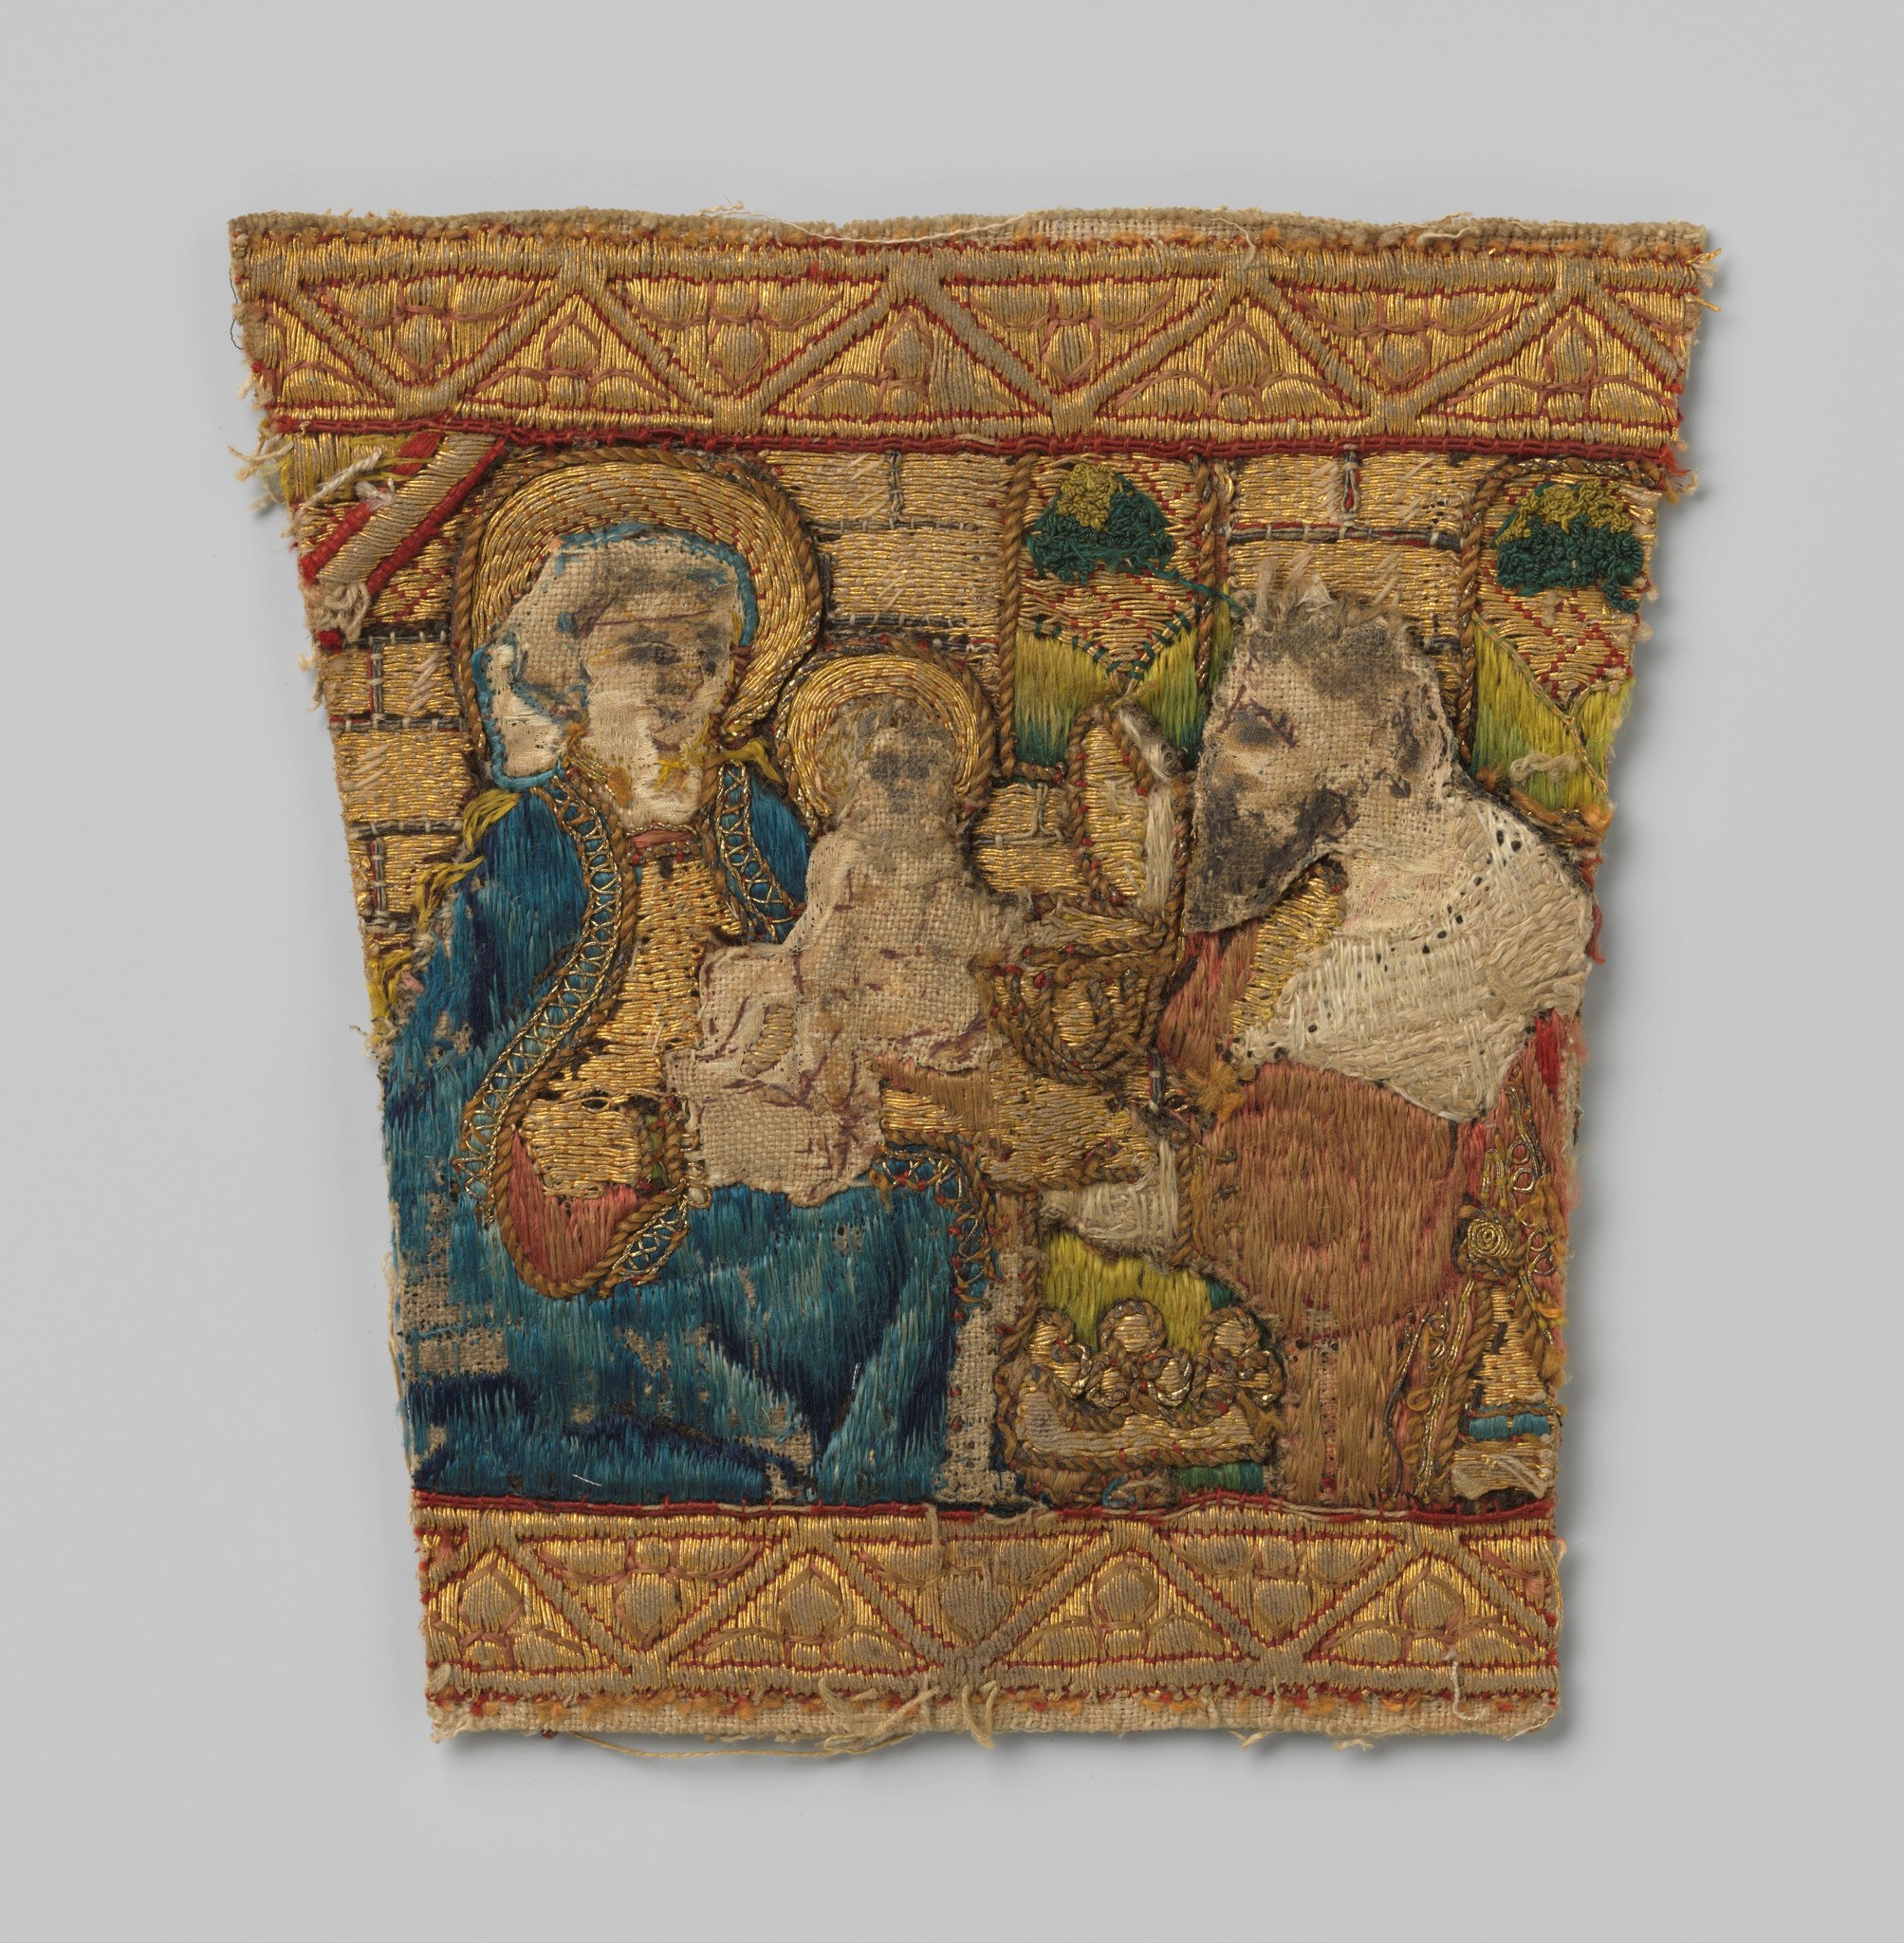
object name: strip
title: Fragment van een strook borduurwerk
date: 1400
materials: gold thread, silk, textile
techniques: embroidered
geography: germany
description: Fragment van een strook borduurwerk. Het borduurwerk heeft een afbeelding van de aanbidding van de koningen. Bij het fragment hoort een fragment met invnr. BK-NM-3609-C.